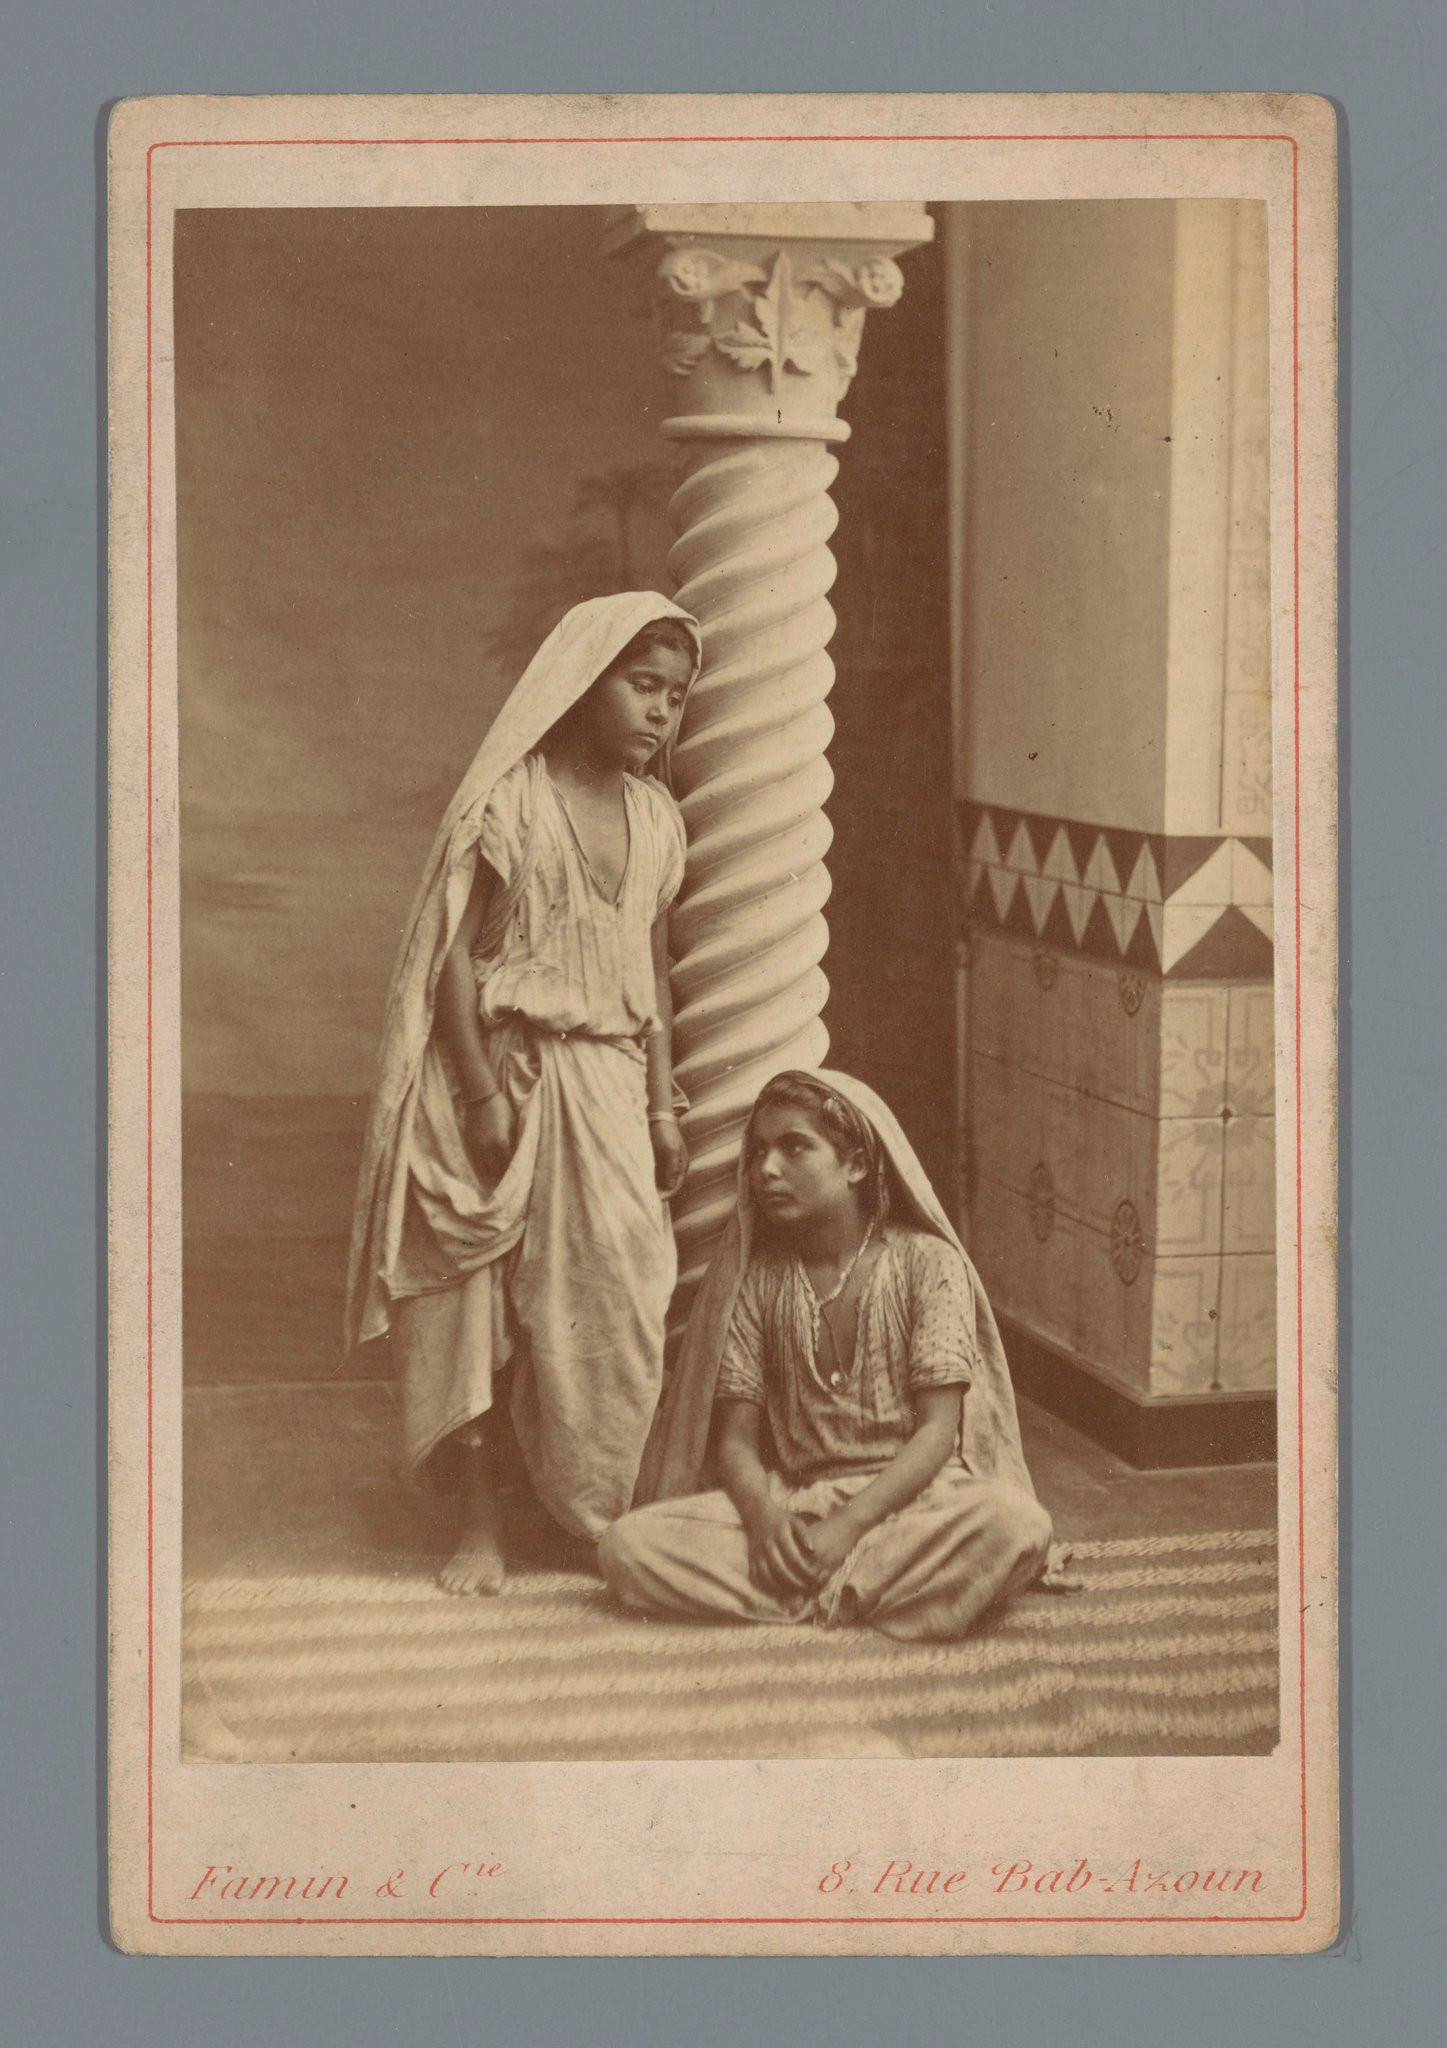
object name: cabinet photograph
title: Twee kinderen voor een zuil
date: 1863-1889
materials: cardboard, photographic support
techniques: albumen print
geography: algeria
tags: youth, adolescent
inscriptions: inscription: ‘8, Rue Bab-Azoun’, inscription: ‘Jeunes Rabyb’, inscription: ‘Alger/ 8, Rue Bab-Azoun, 8’